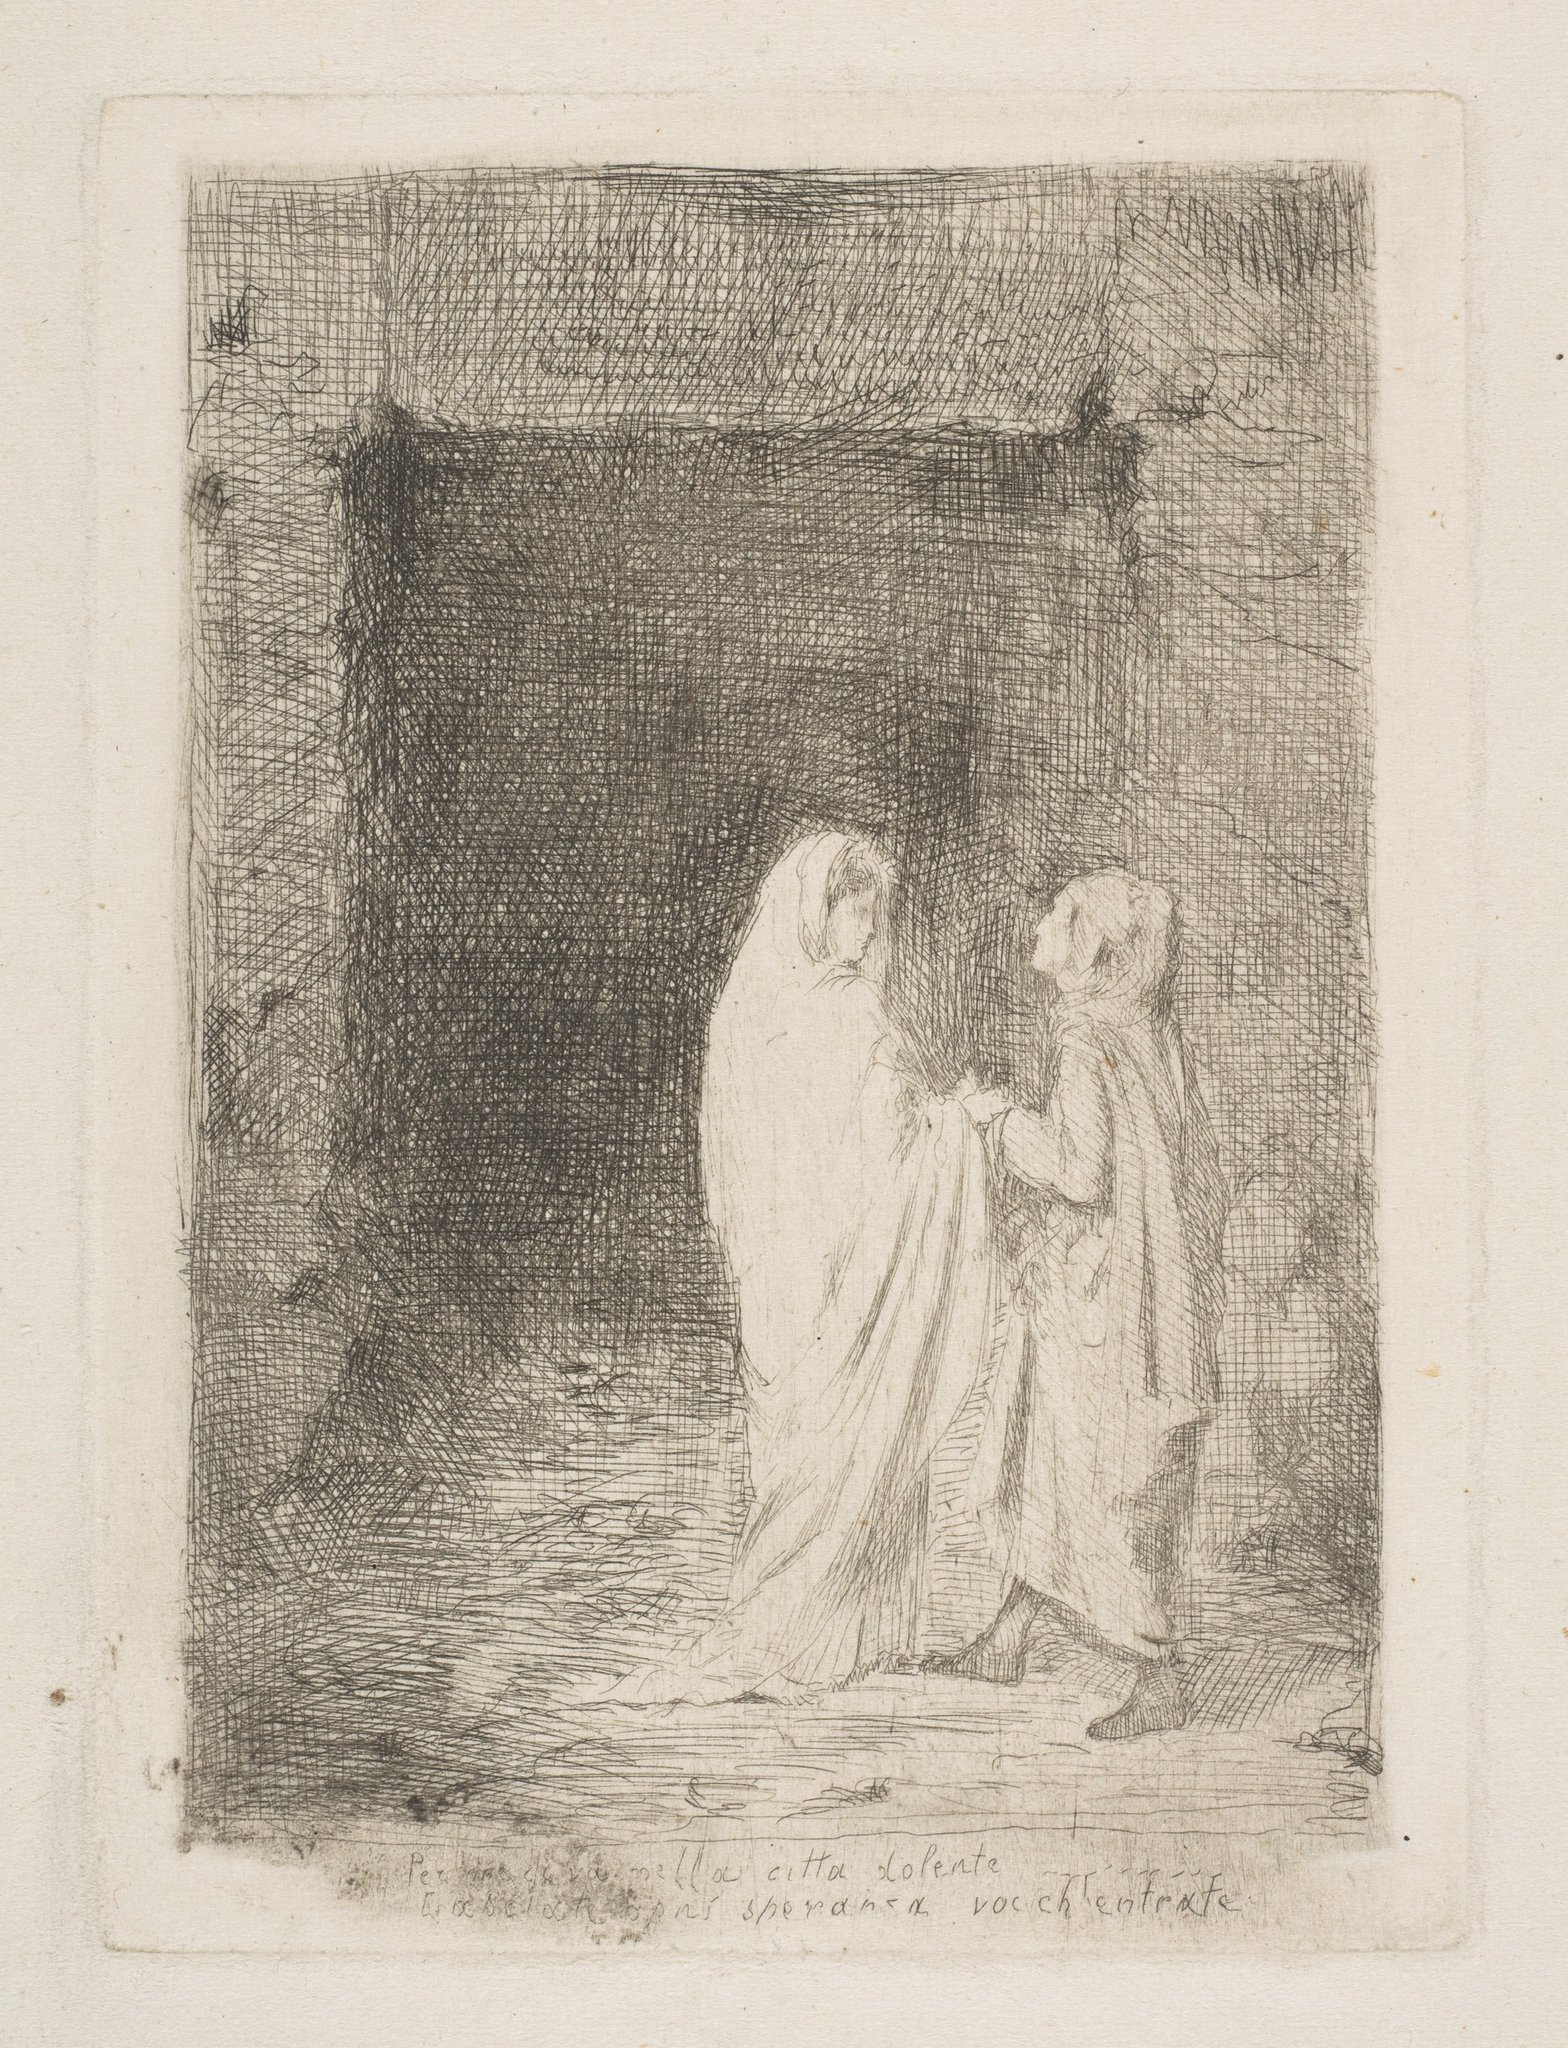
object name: print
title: Dante and Virgil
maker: edgar degas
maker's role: artist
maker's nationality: french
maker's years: 1834-1917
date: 1857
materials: paper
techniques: drypoint, etching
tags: men